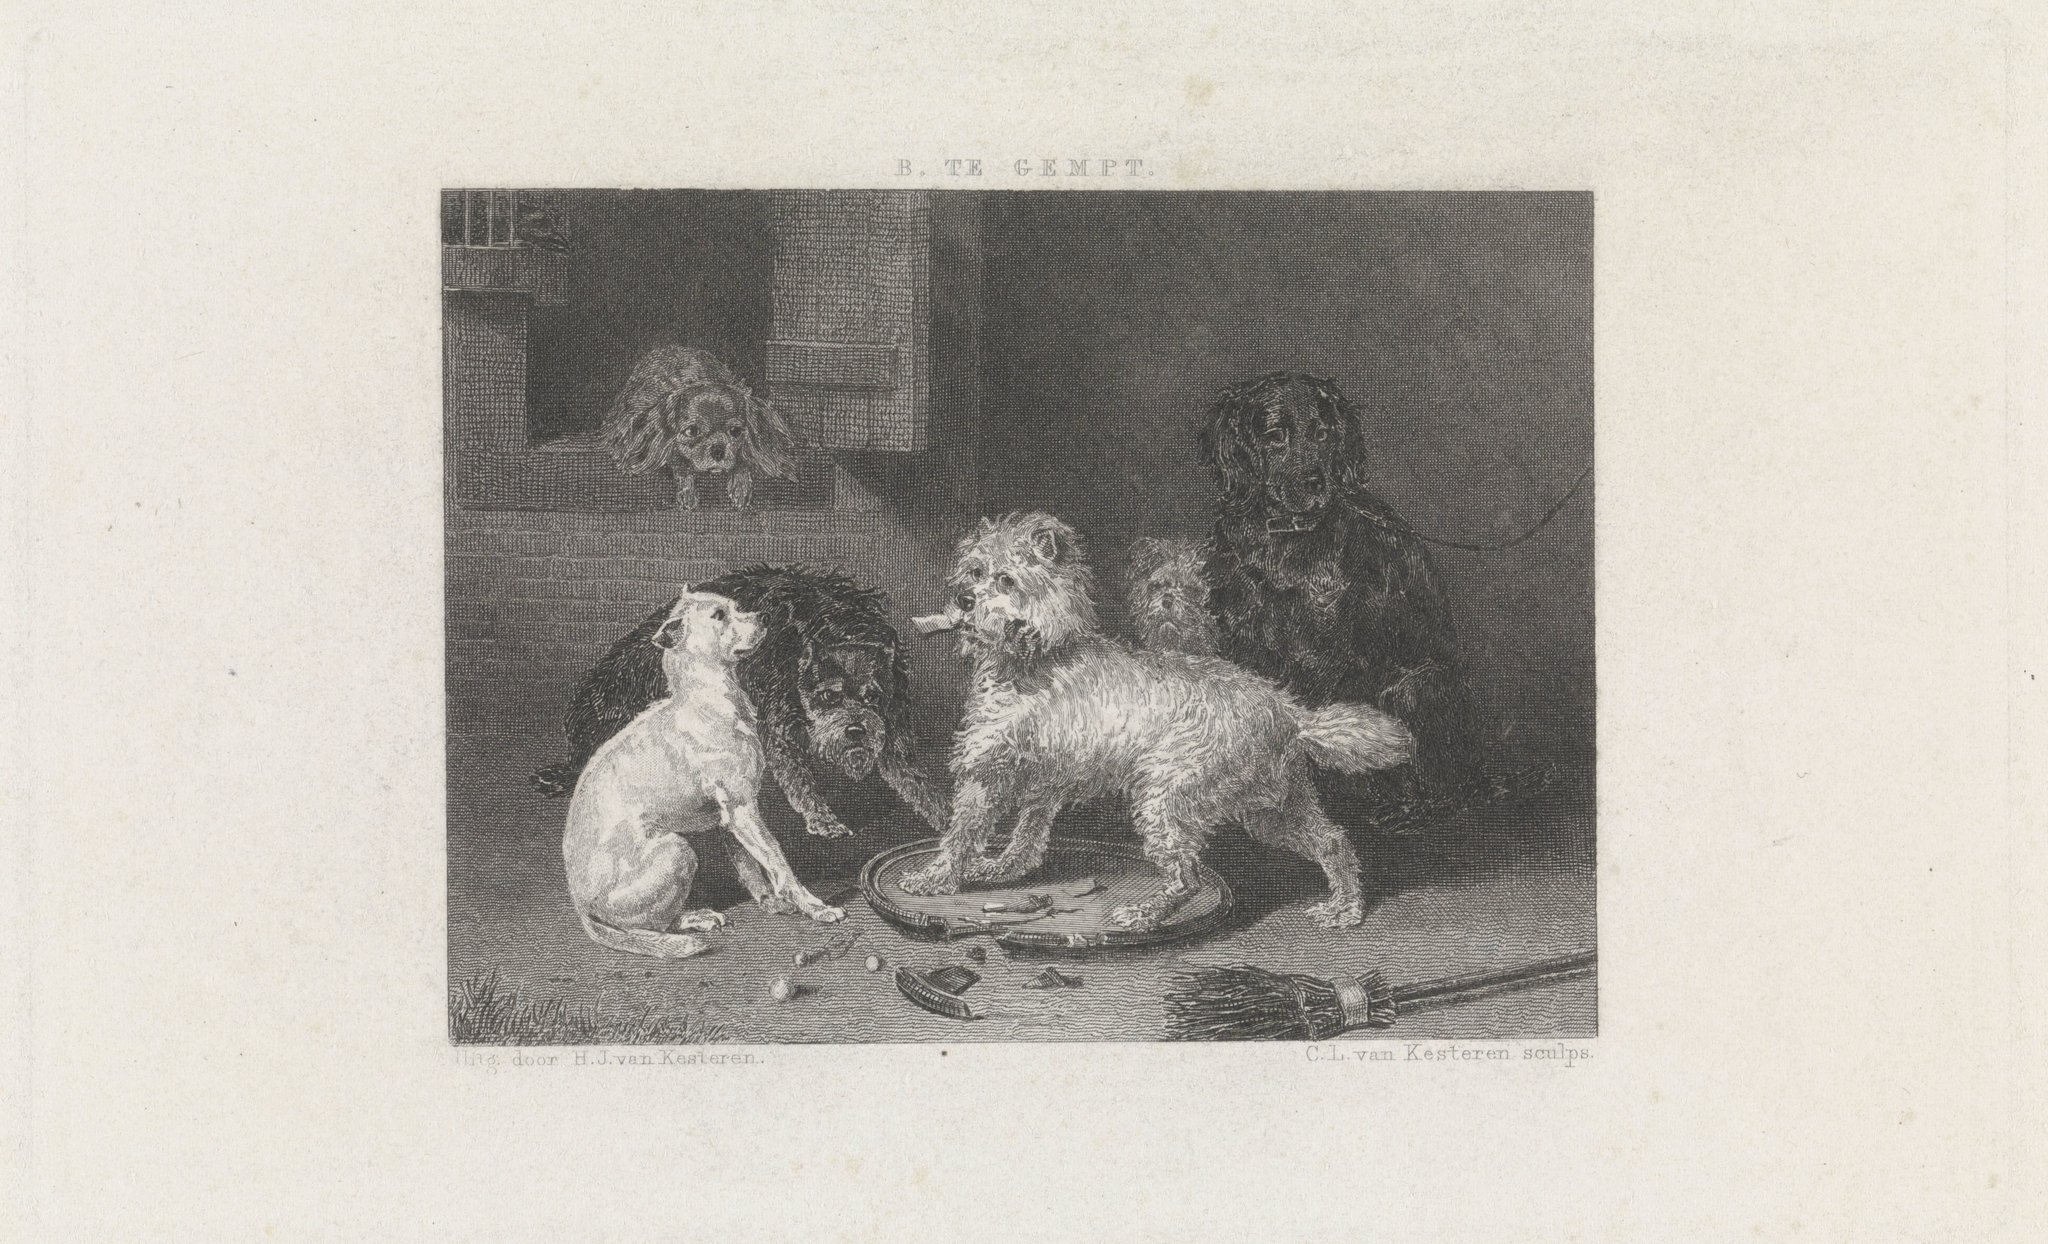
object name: print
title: Diverse honden bij een muur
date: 1886-1897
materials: paper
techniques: engraving, etching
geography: amsterdam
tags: shrubs, dog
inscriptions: collector's mark: Lugt 2228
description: Zes honden voor een huis. De Cavalier King Charles zit in het venster en in het midden staat een witte hond op een dienblad.